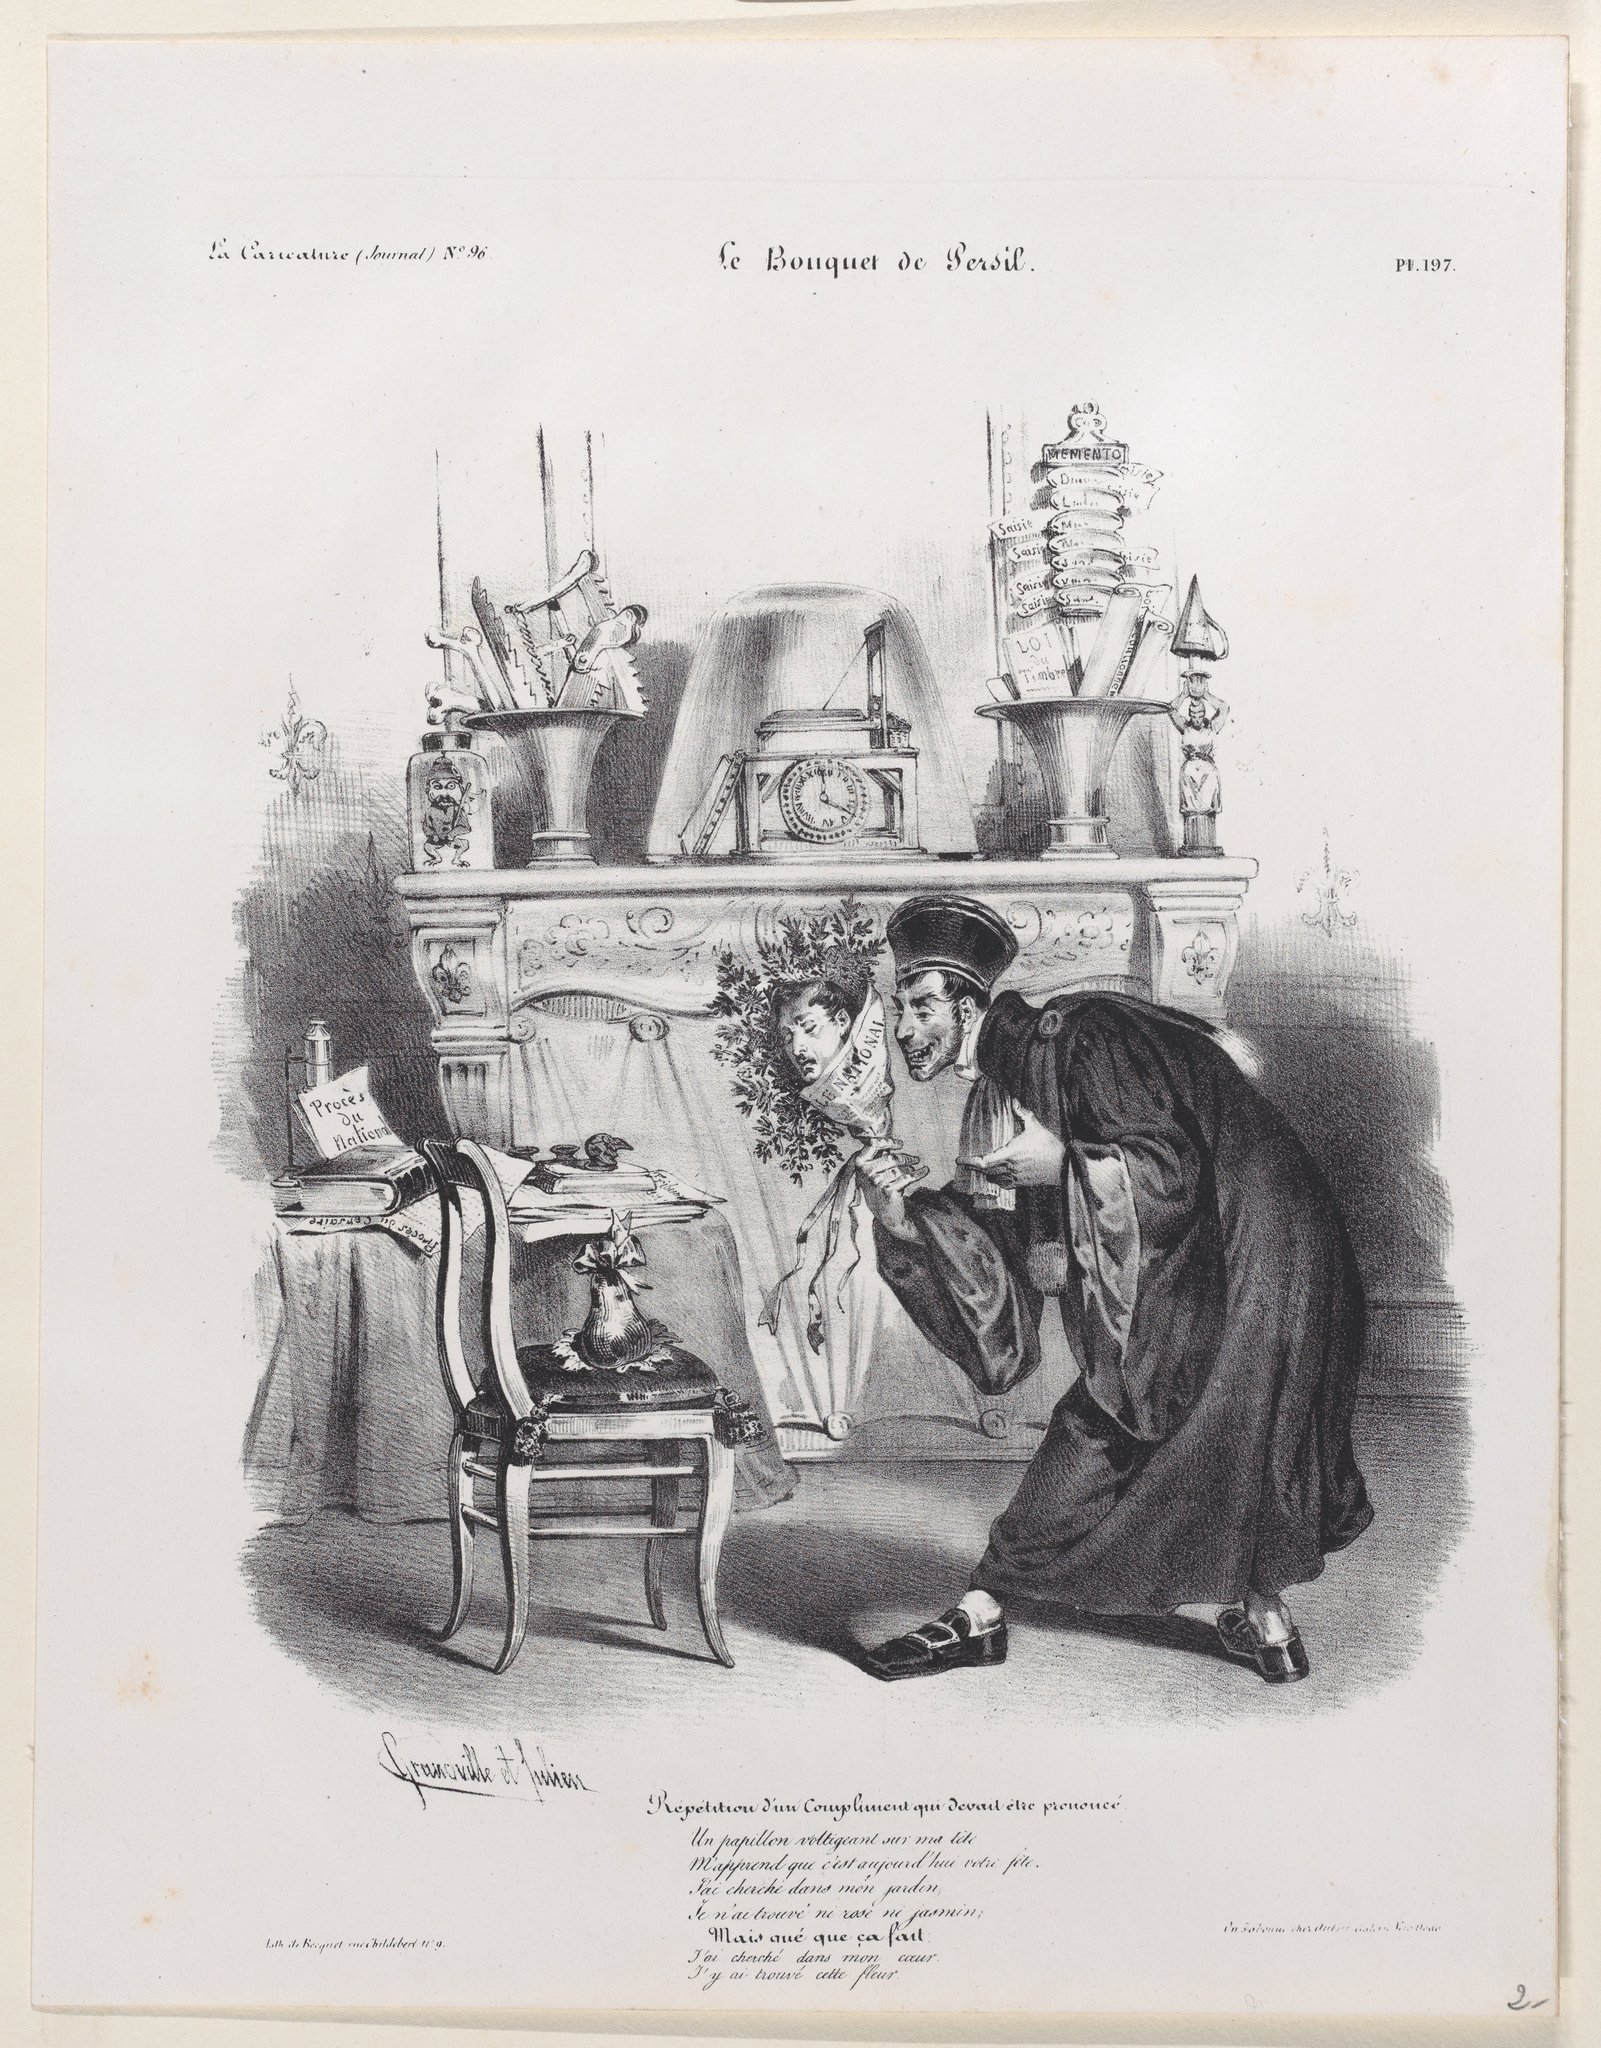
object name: print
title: The Parsley Bouquet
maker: j. j. grandville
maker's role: artist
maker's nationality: french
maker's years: 1803-1847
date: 1832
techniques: lithograph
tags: satire,men,caricature